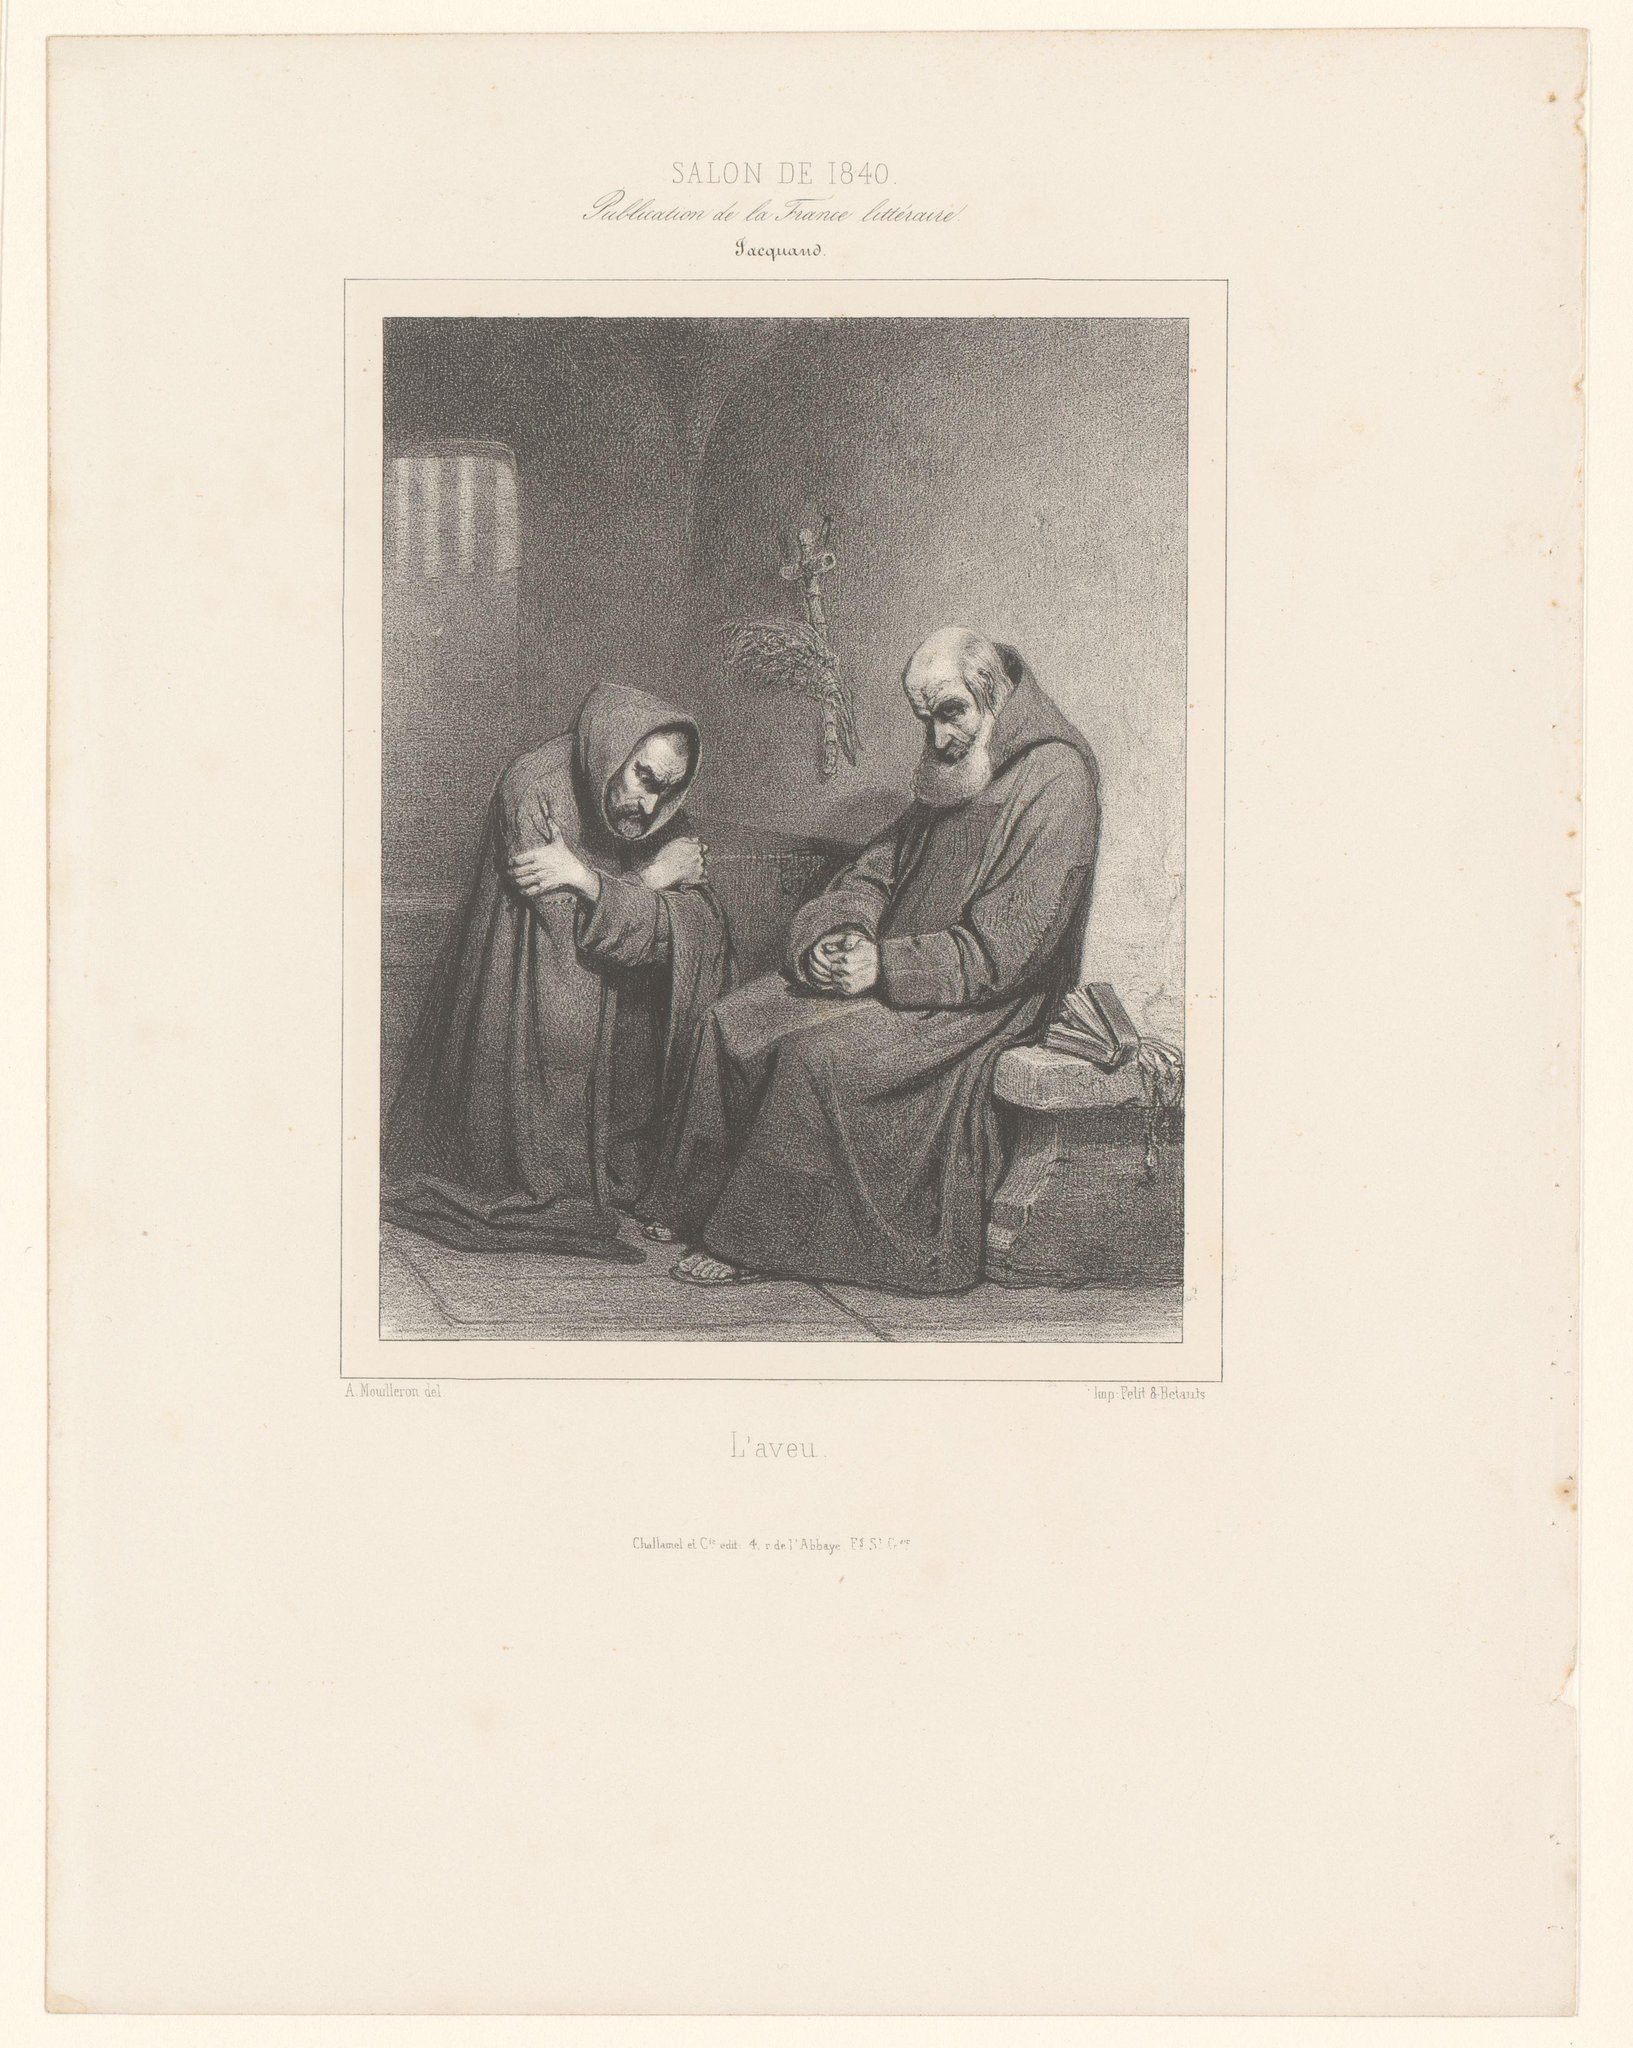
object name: print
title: L'aveu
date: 1840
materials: paper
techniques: lithograph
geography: paris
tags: monk(s), friar(s)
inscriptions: collector's mark: Lugt 2228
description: Prent verschenen in: La France littéraire, 1840, nr. 3.